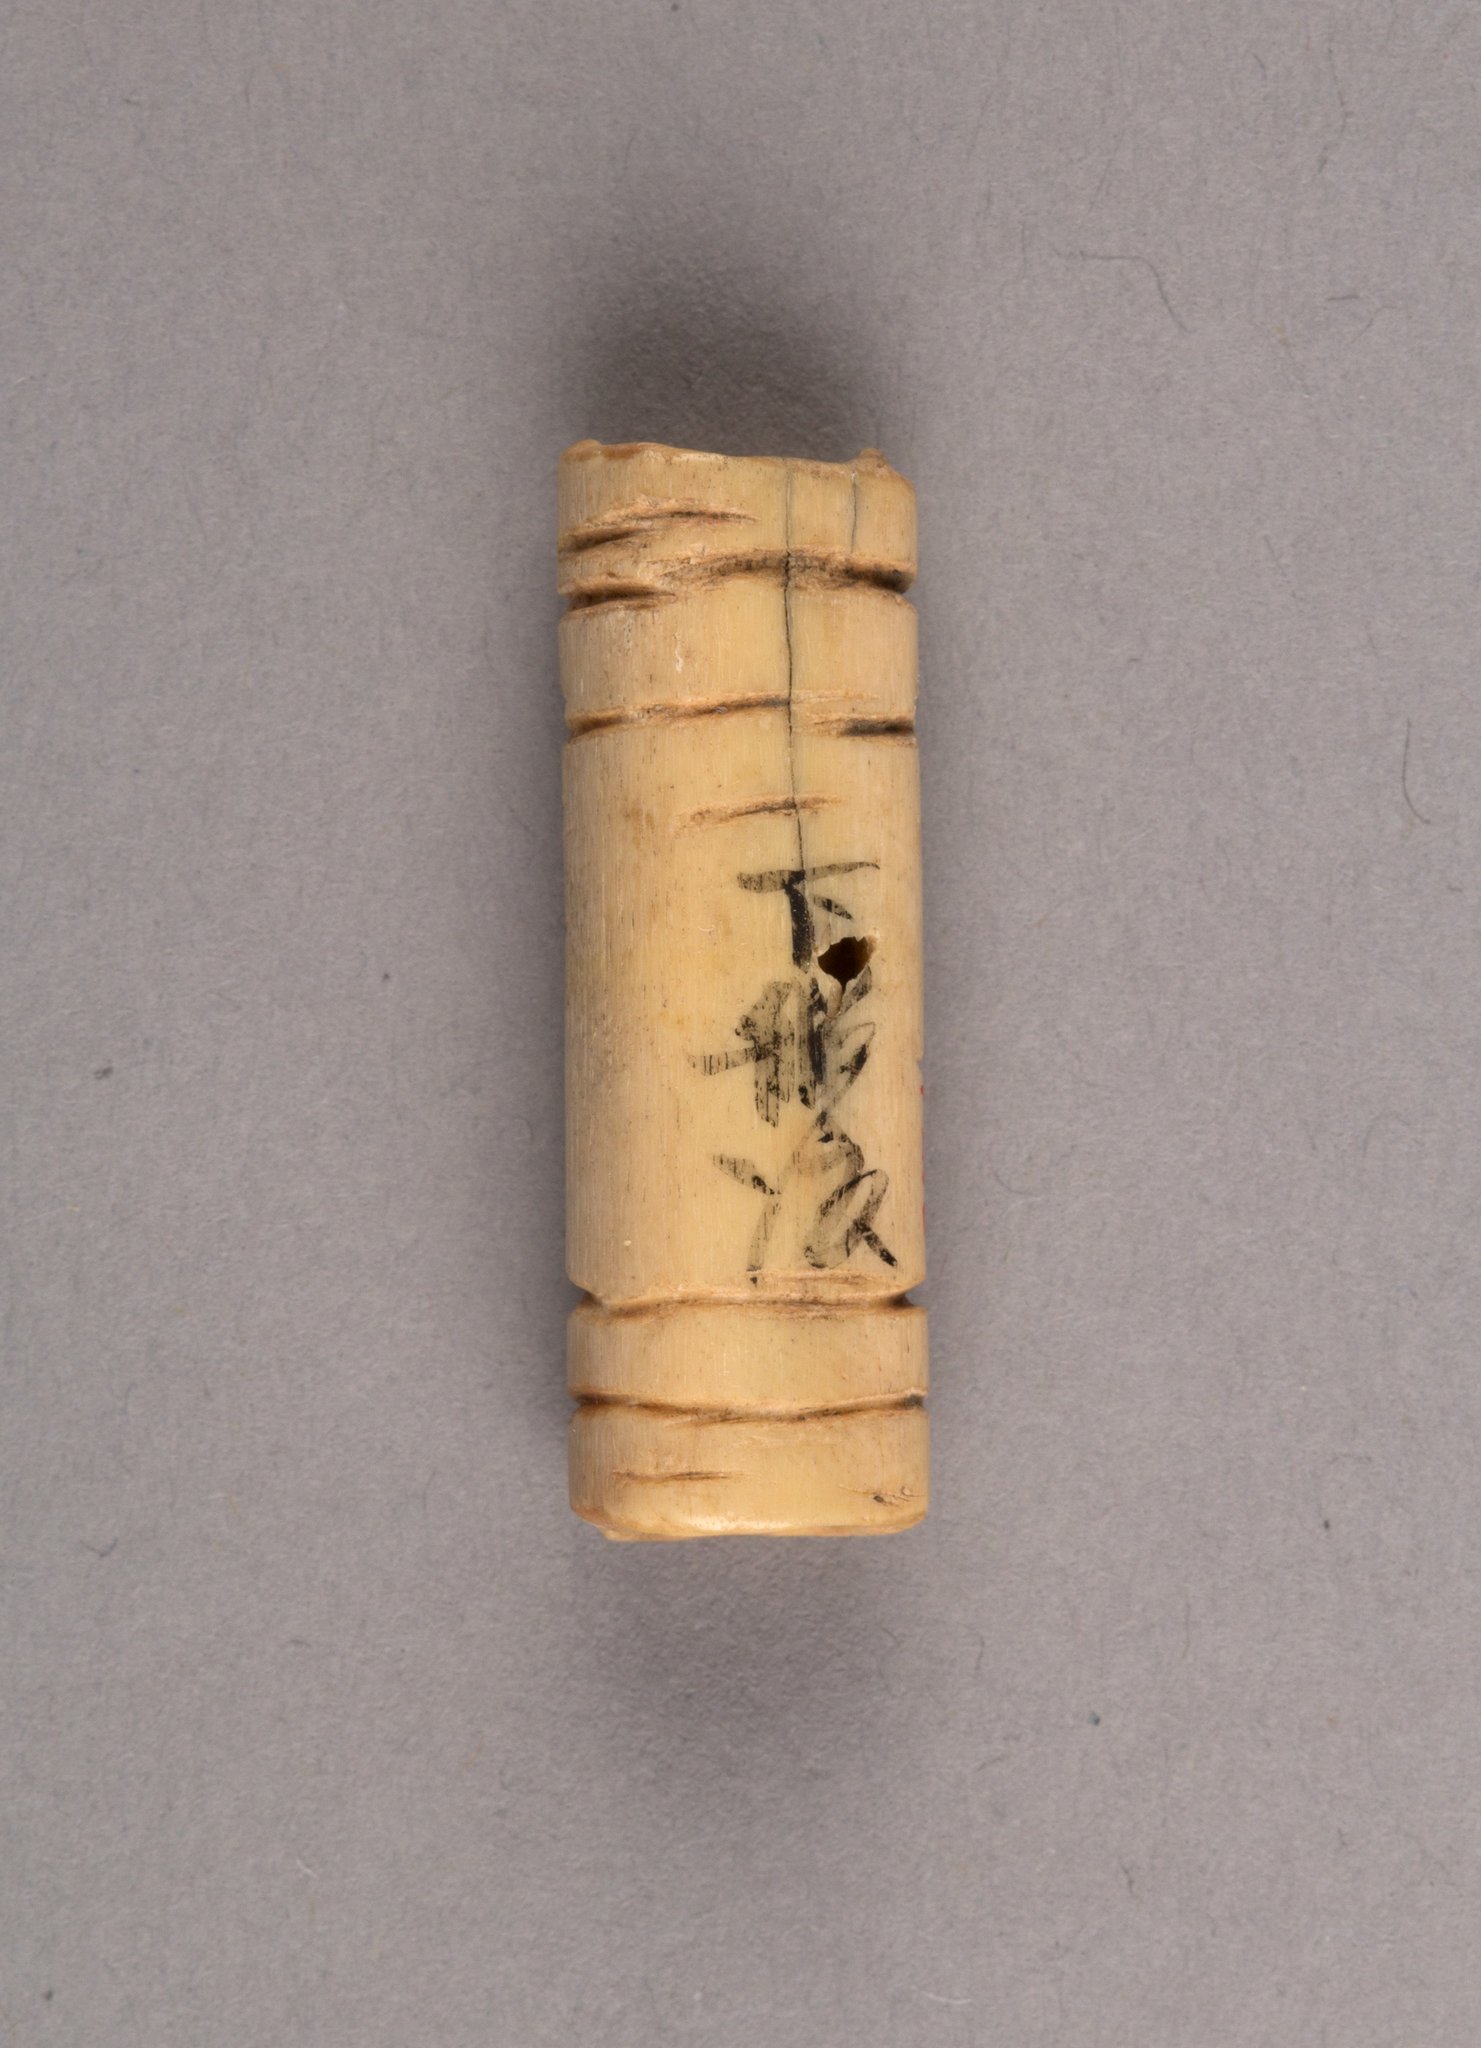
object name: arrowhead, needle, hook and harpoon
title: Arrowheads, needles, hooks and harpoons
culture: japanese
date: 1000-300 BCE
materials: bone